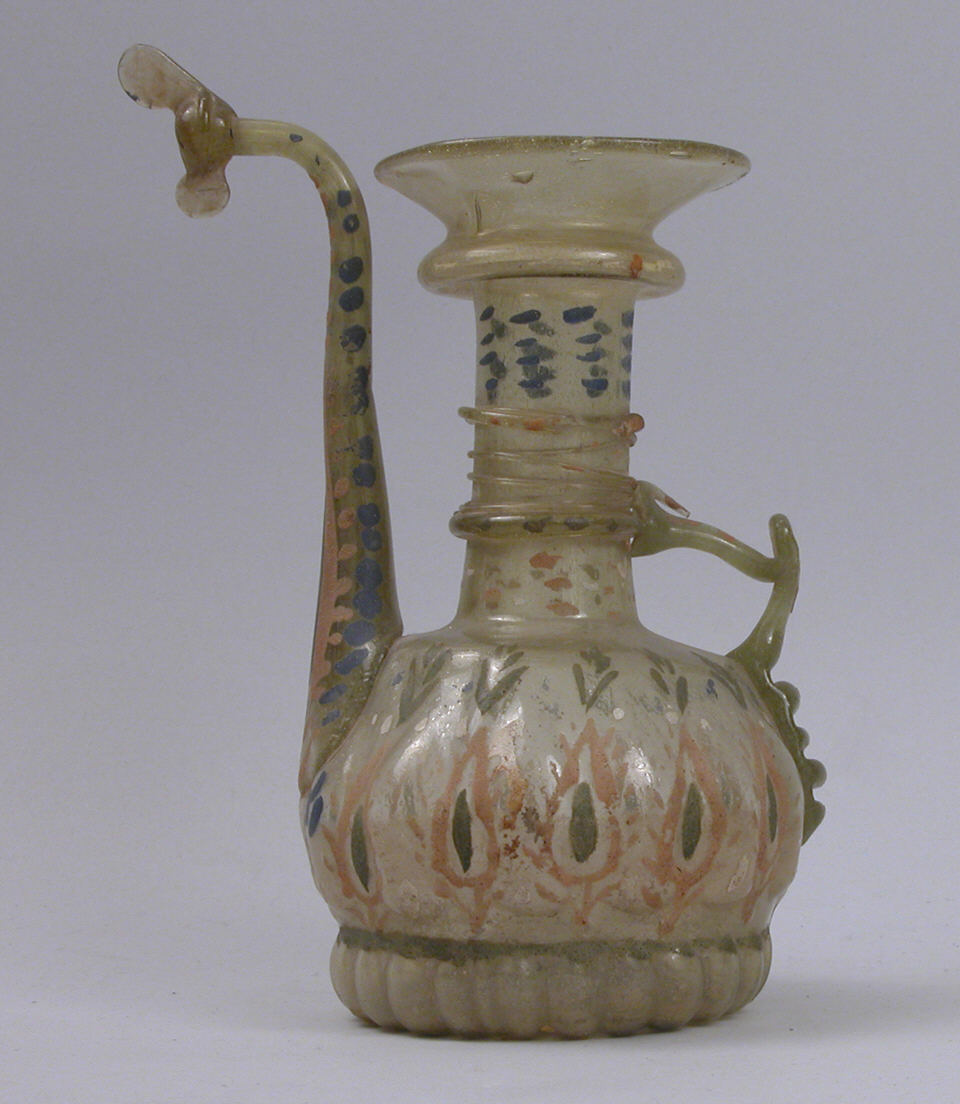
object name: ewer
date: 1701-1900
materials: glass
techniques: glassblowing, painting, tooling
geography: iran